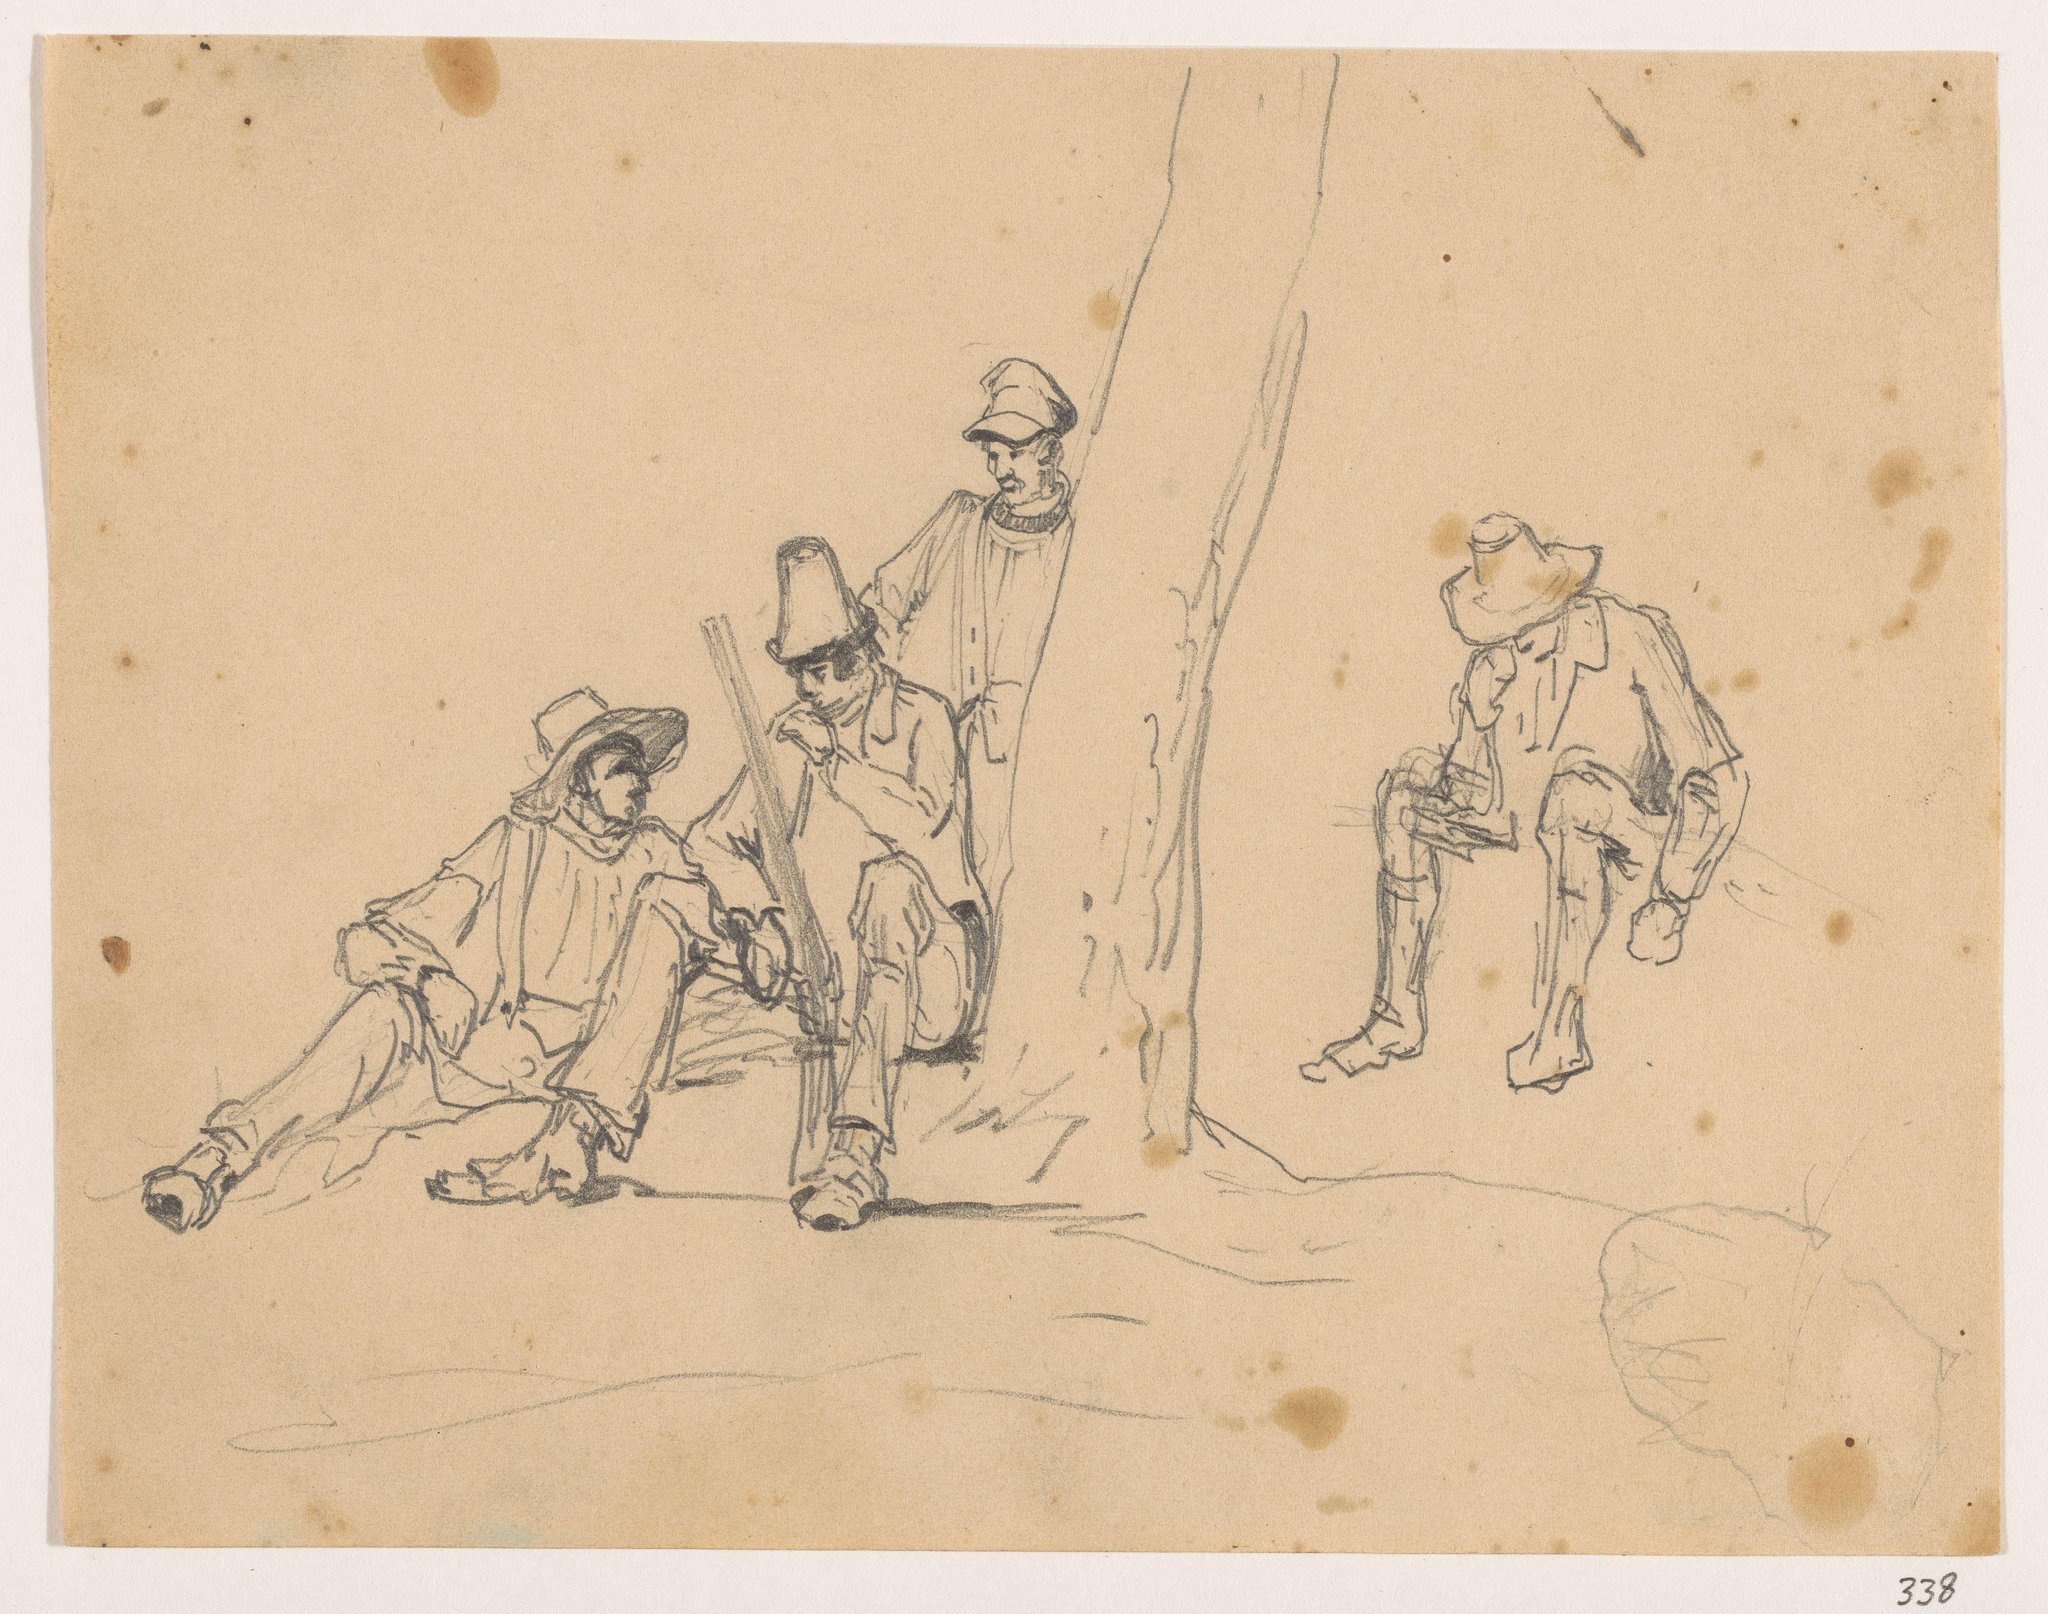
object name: drawing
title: Rustende jagers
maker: johannes tavenraat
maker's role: draughtsman, painter, print maker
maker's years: 1809-1881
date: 1840-1880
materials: paper, pencil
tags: hunters resting during the hunt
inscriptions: collector's mark: Lugt 2228